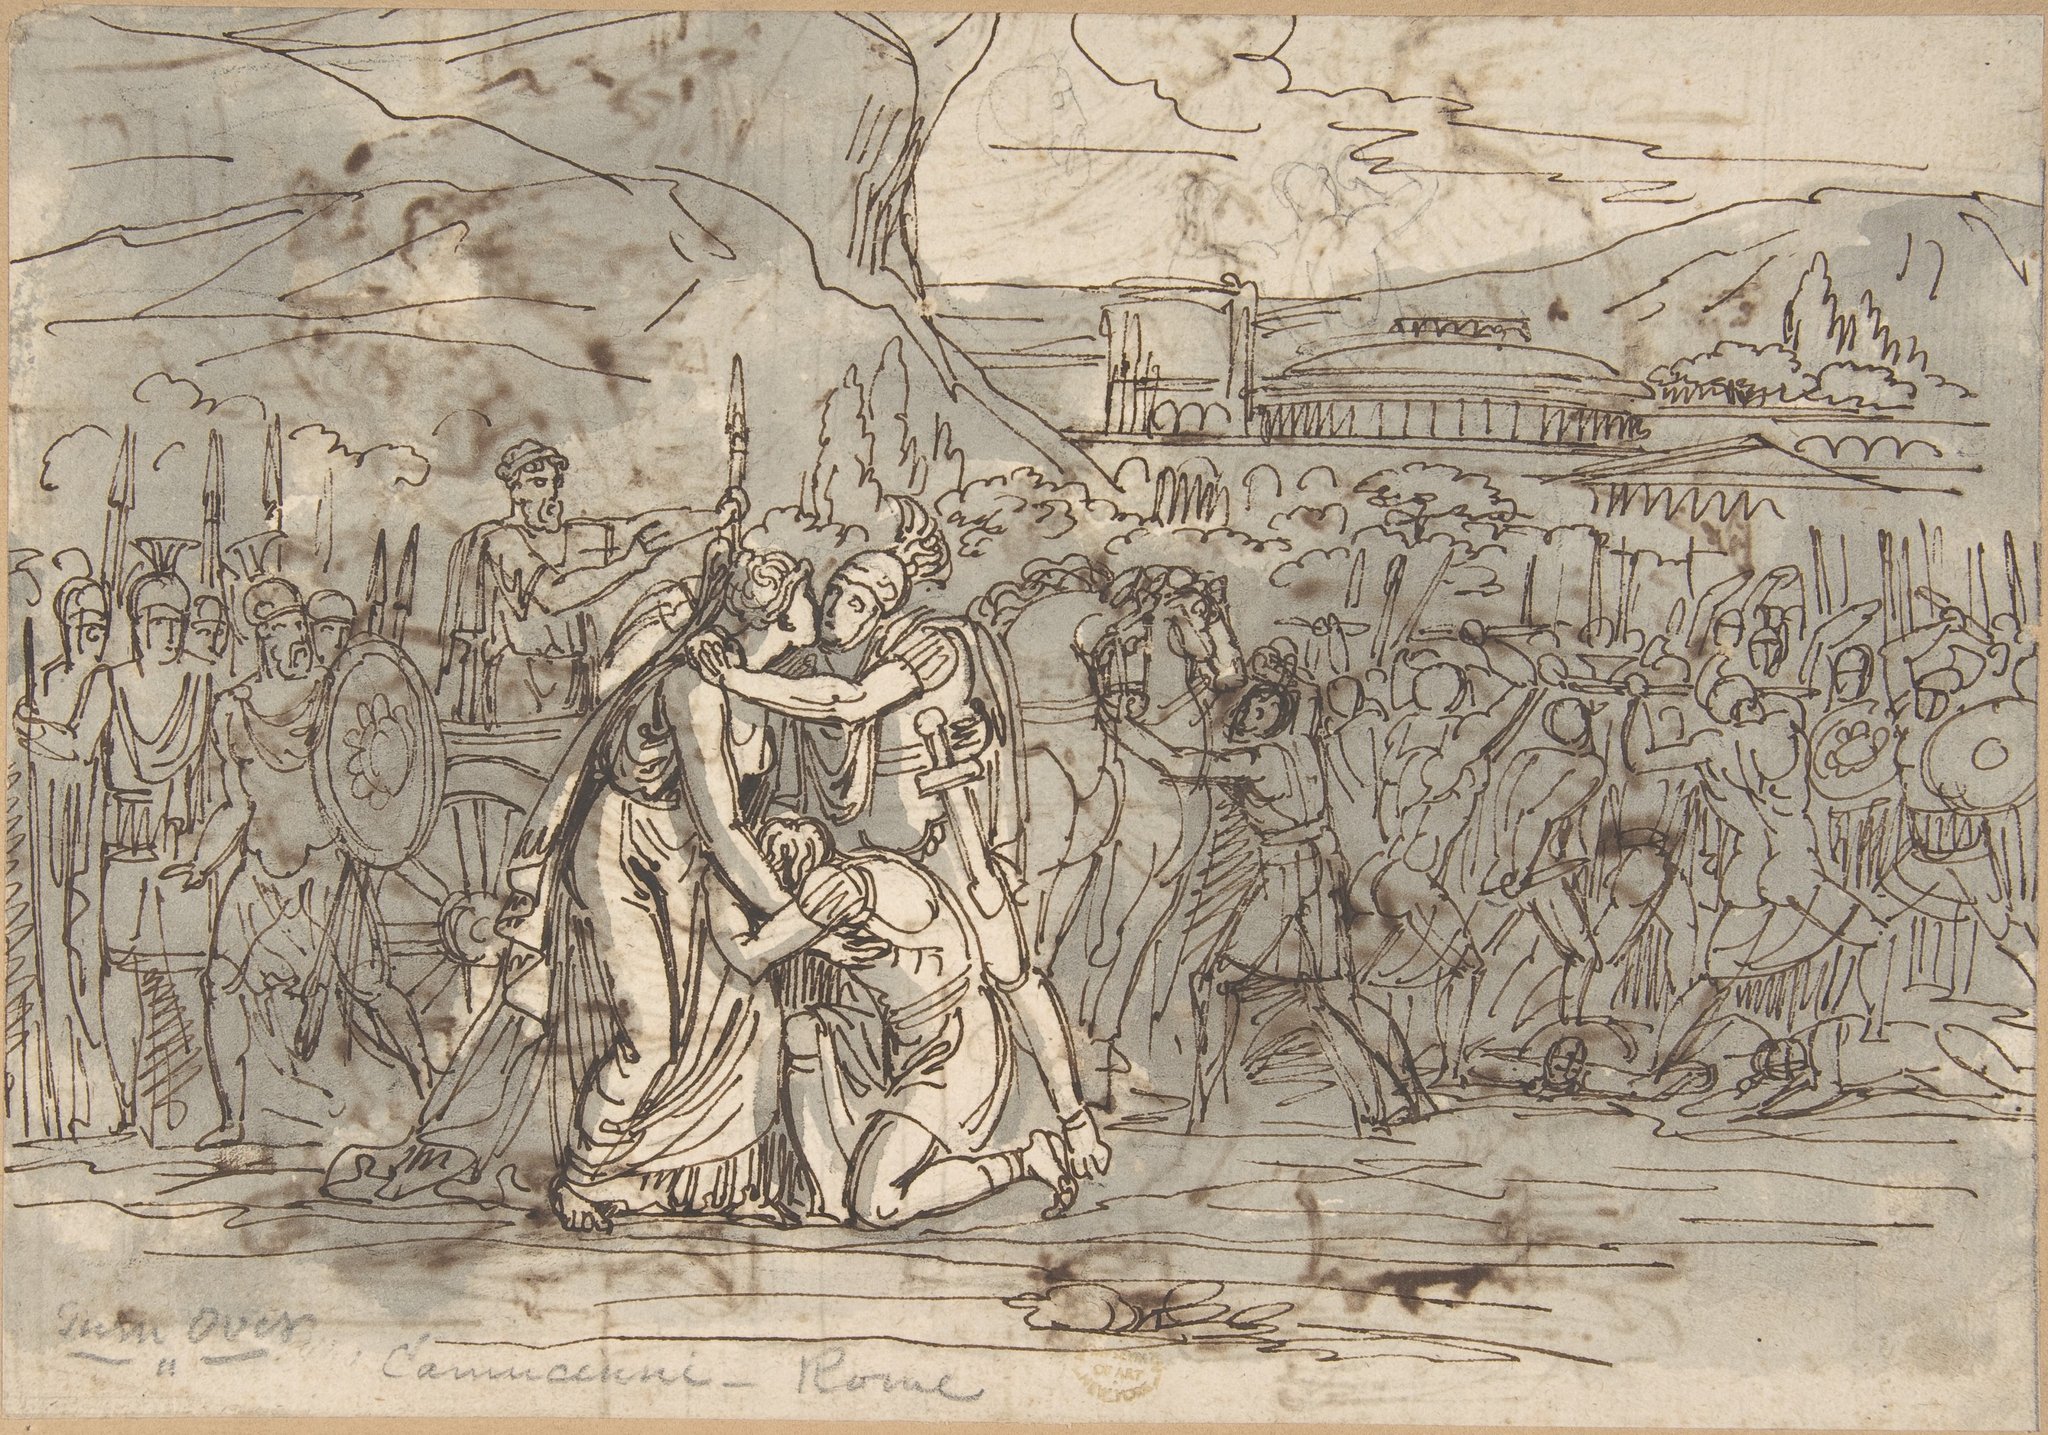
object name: drawing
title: Soldiers Going into Battle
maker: vincenzo camuccini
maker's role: artist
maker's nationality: italian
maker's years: 1771-1844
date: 1795-1844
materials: ink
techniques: brush, pen, wash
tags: battles,soldiers,men,women,chariots